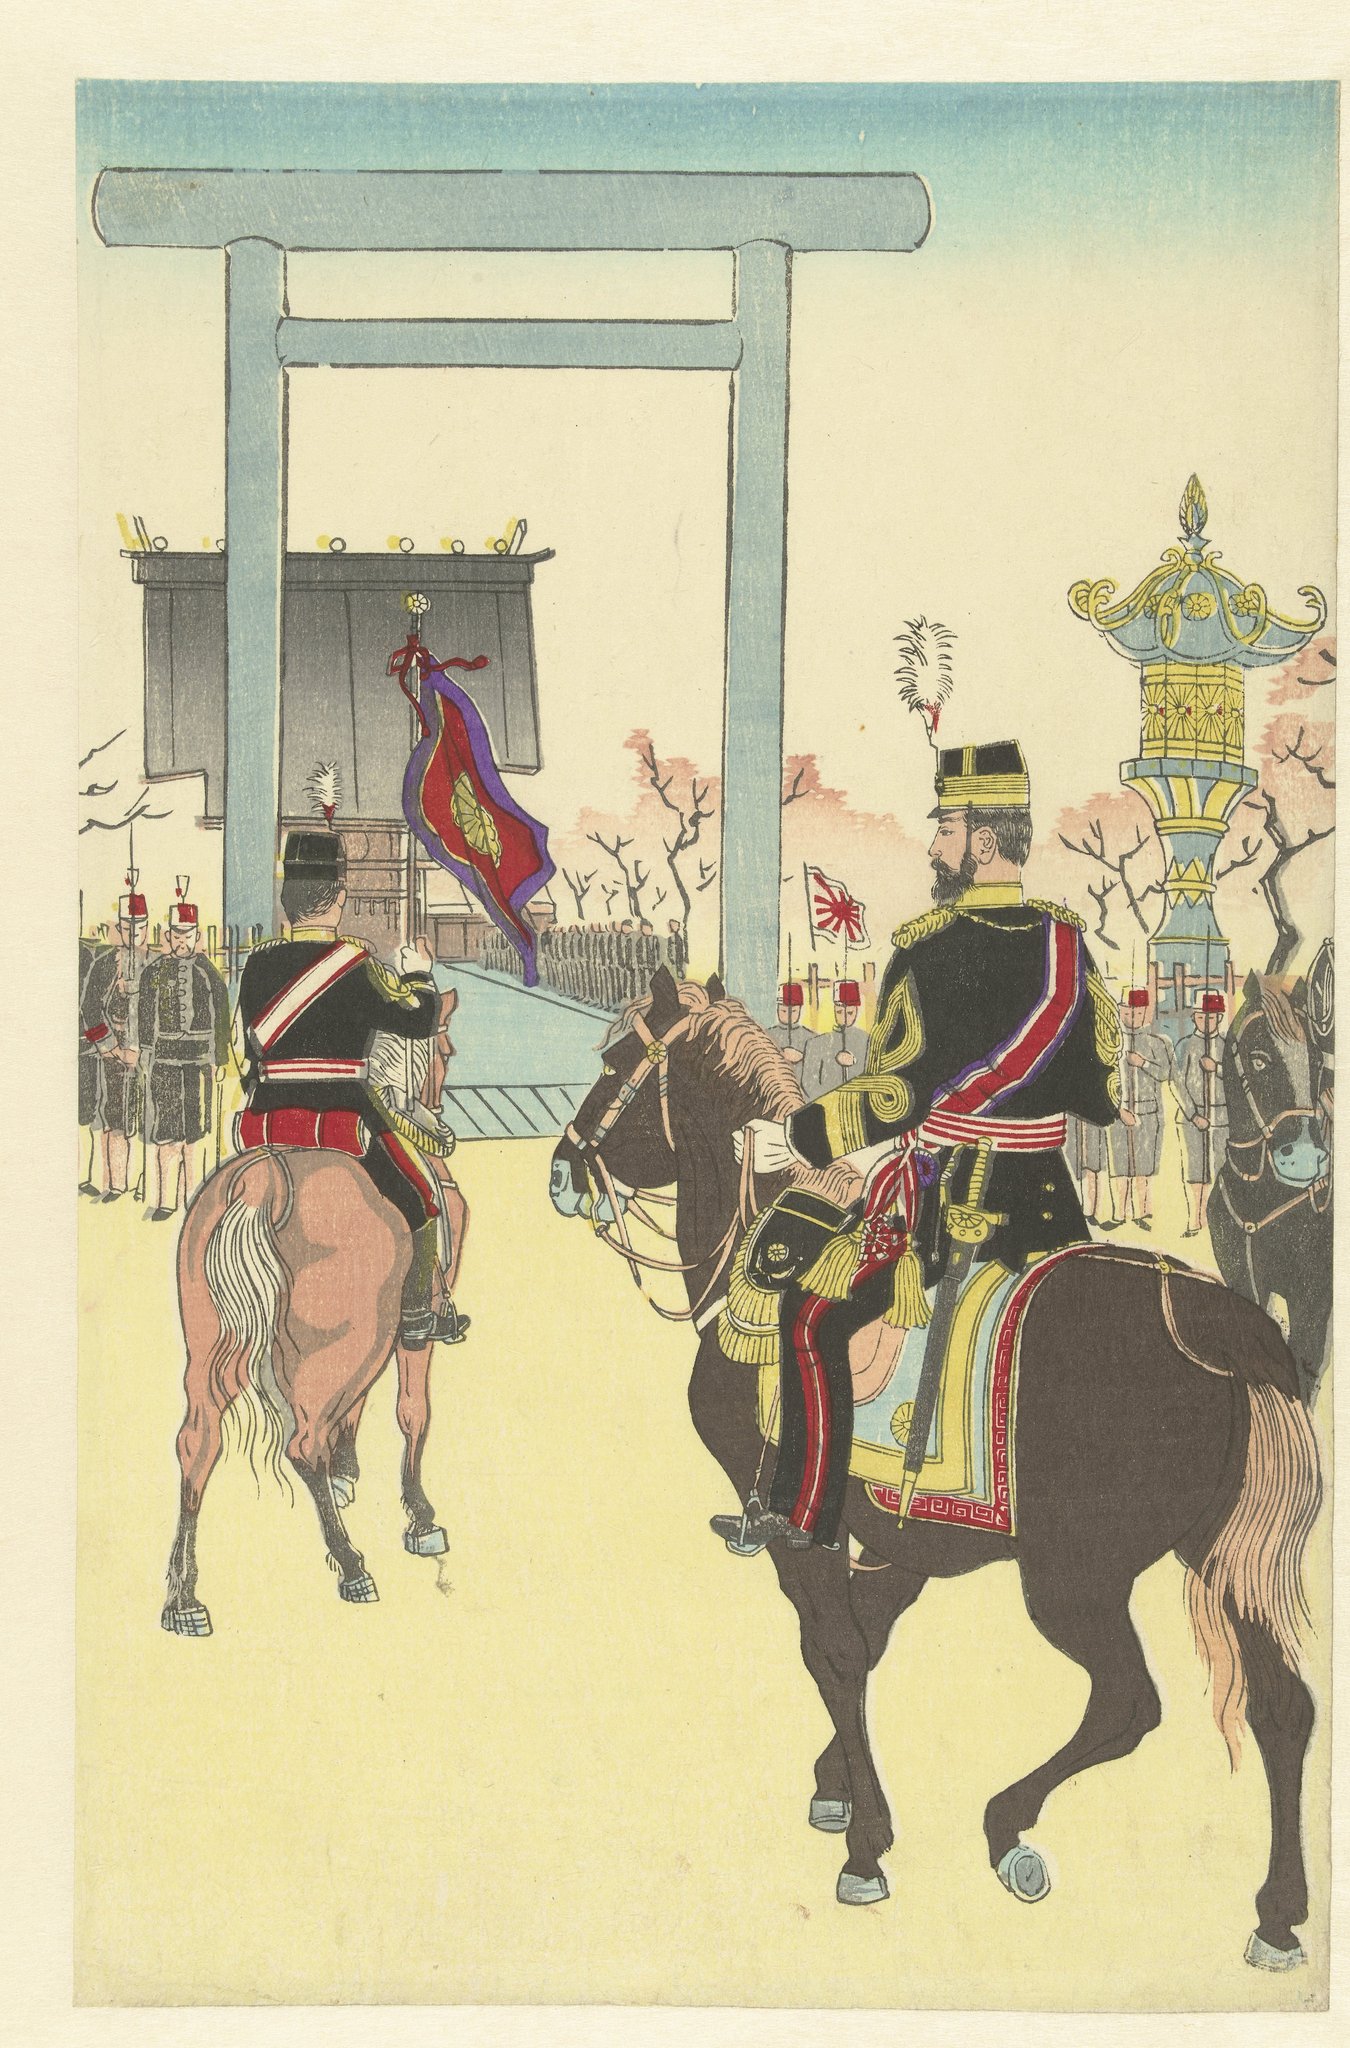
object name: print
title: Grote ceremonie bij het Yasukuni heiligdom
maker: shinsai kiyooki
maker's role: print maker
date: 1895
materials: paper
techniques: woodcut, nishiki e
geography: japan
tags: riding a horse, ass, or mule; rider, horseman, gate, entrance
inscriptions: collector's mark: Lugt 2228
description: Mannen te paard bij een grote torii (toegangspoort naar een Shinto heiligdom), waarachter het houten Yasukuni heiligdom. Middelste blad van een drieluik.